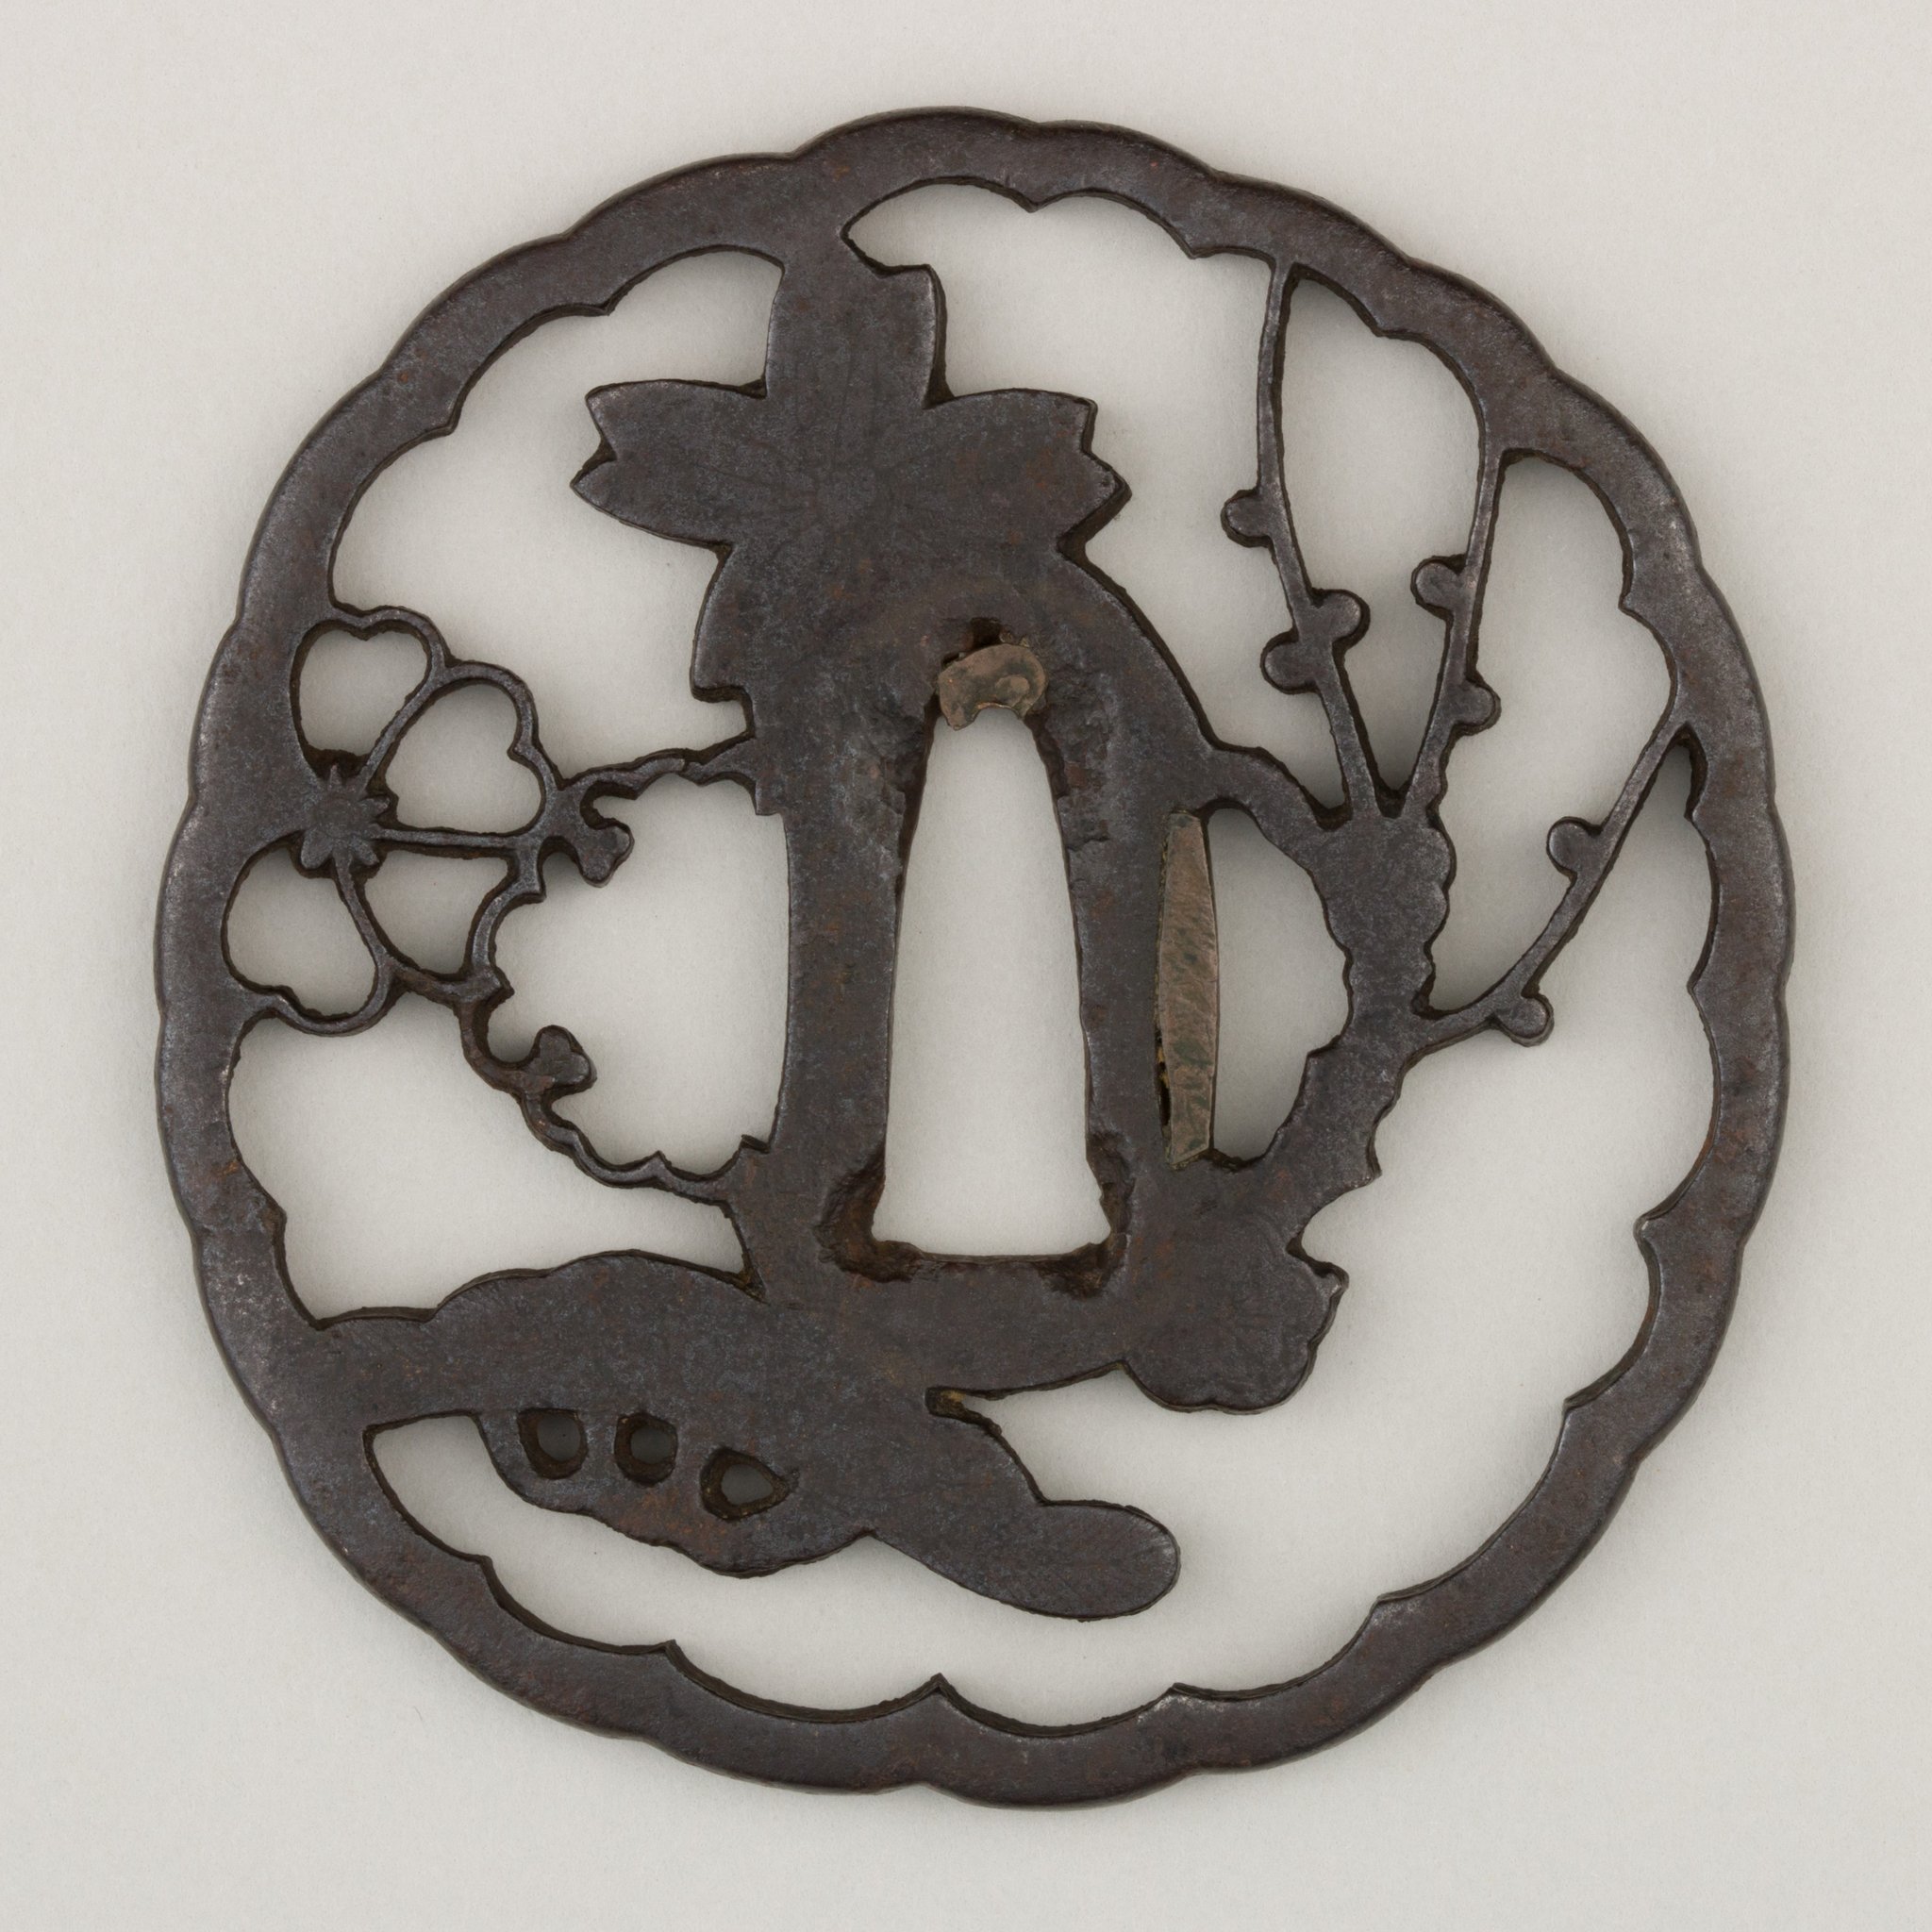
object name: sword guard tsuba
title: Sword Guard (Tsuba)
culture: japanese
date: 1601-1800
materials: copper, iron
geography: japan